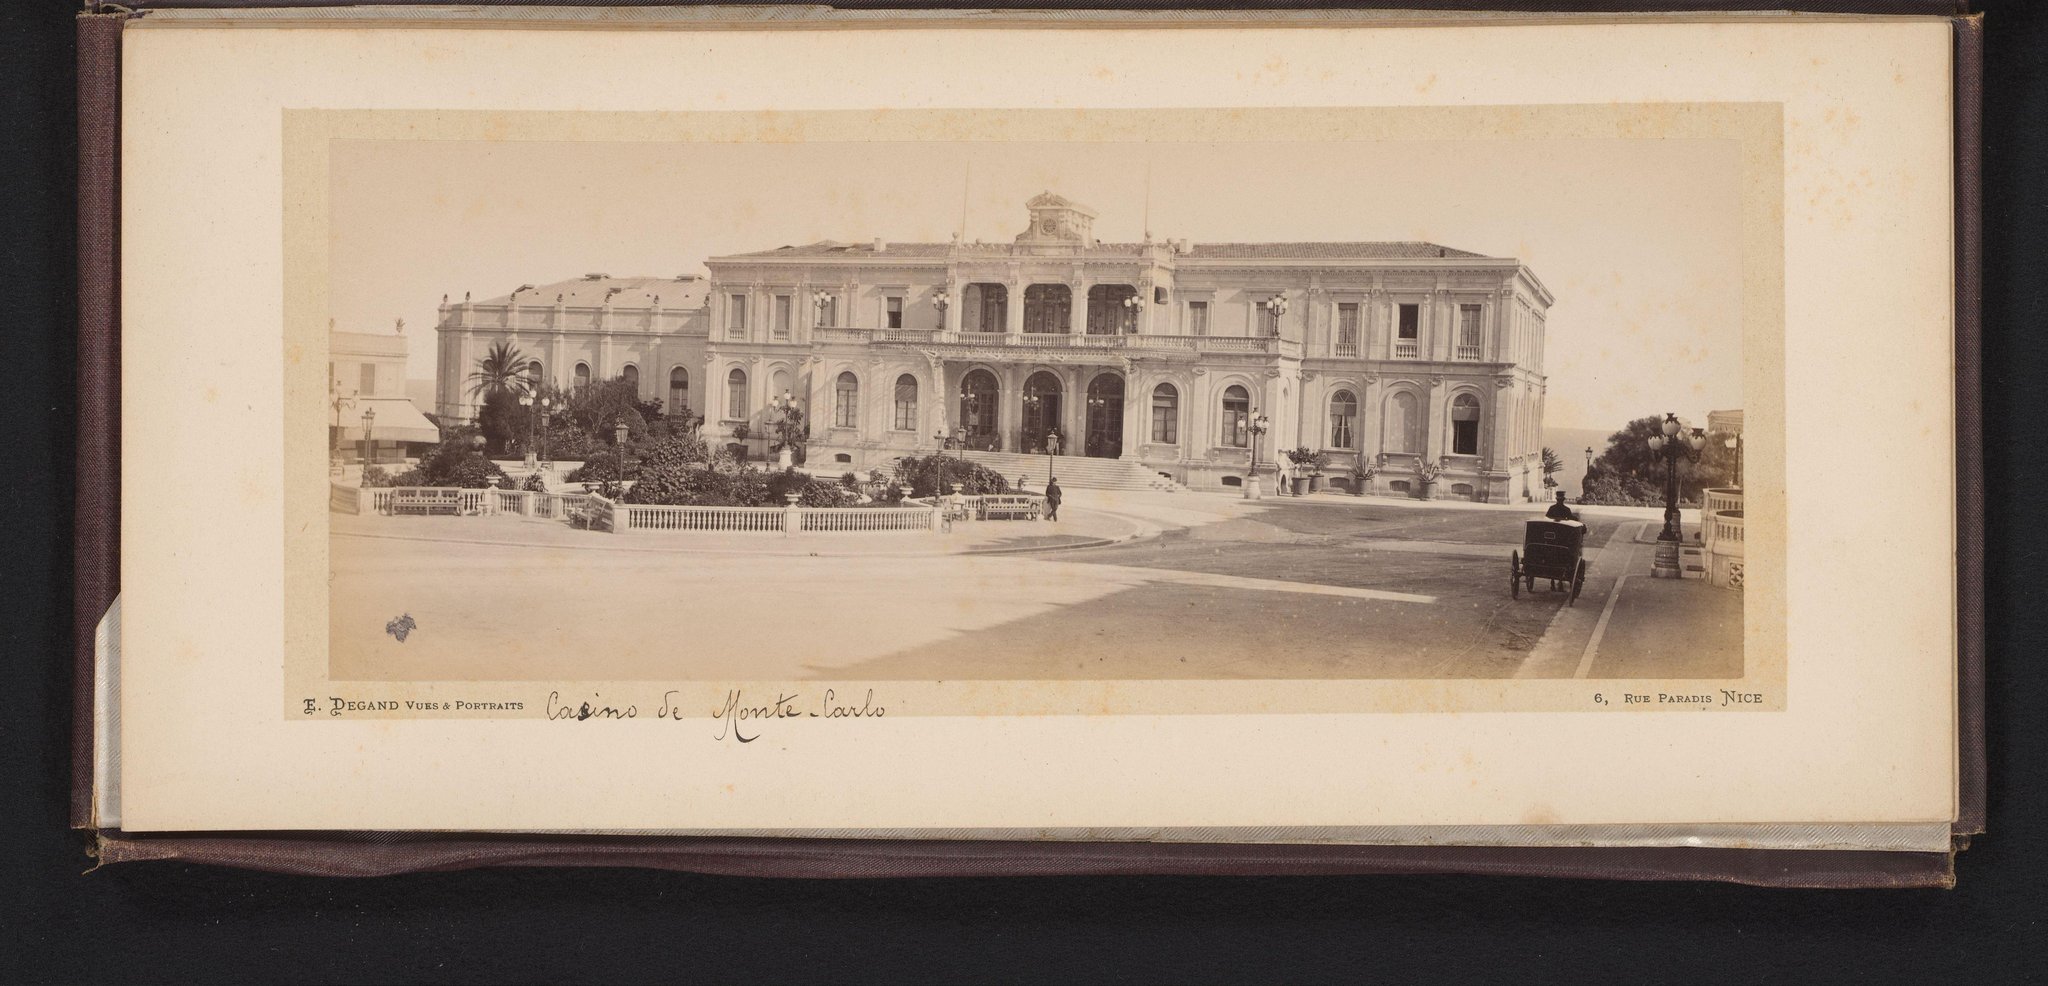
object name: photograph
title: Gezicht op Monte Carlo Casino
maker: eugène degand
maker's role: painter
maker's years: 1829-1911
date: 1872-1874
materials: cardboard, photographic support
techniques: albumen print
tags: casino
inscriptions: inscription: ‘E. Degand Vues&Portraits 6, Rue Paradis Nice’, annotation: ‘Casino de Monte Carlo’